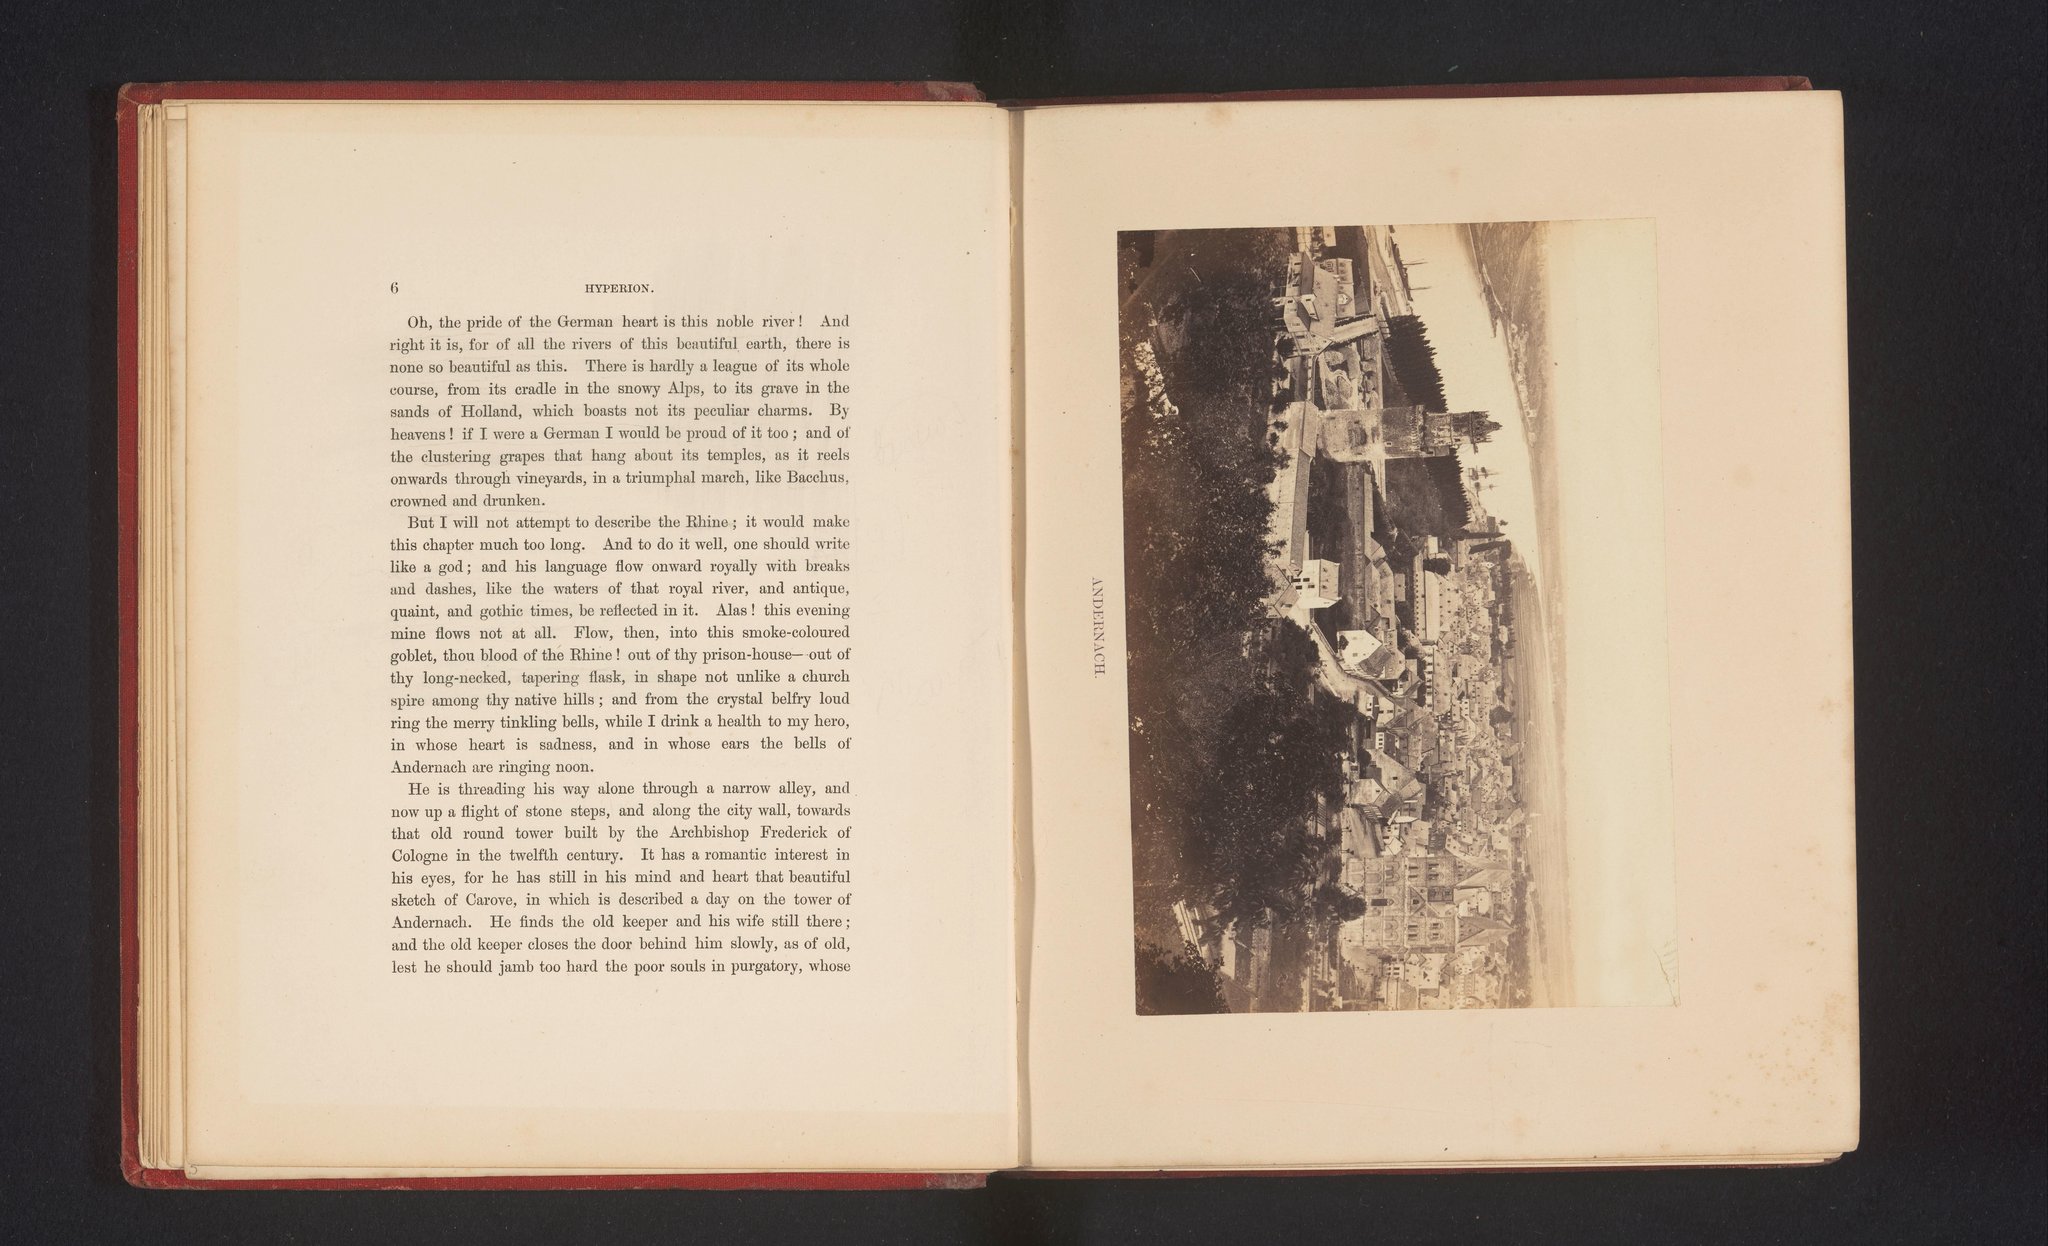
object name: photograph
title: Gezicht op Andernach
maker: francis frith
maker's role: publisher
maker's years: 1822-1898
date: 1855-1865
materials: photographic support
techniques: albumen print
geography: andernach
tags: city-view, and landscape with man-made constructions, tower, clock tower ~ monumental adornment